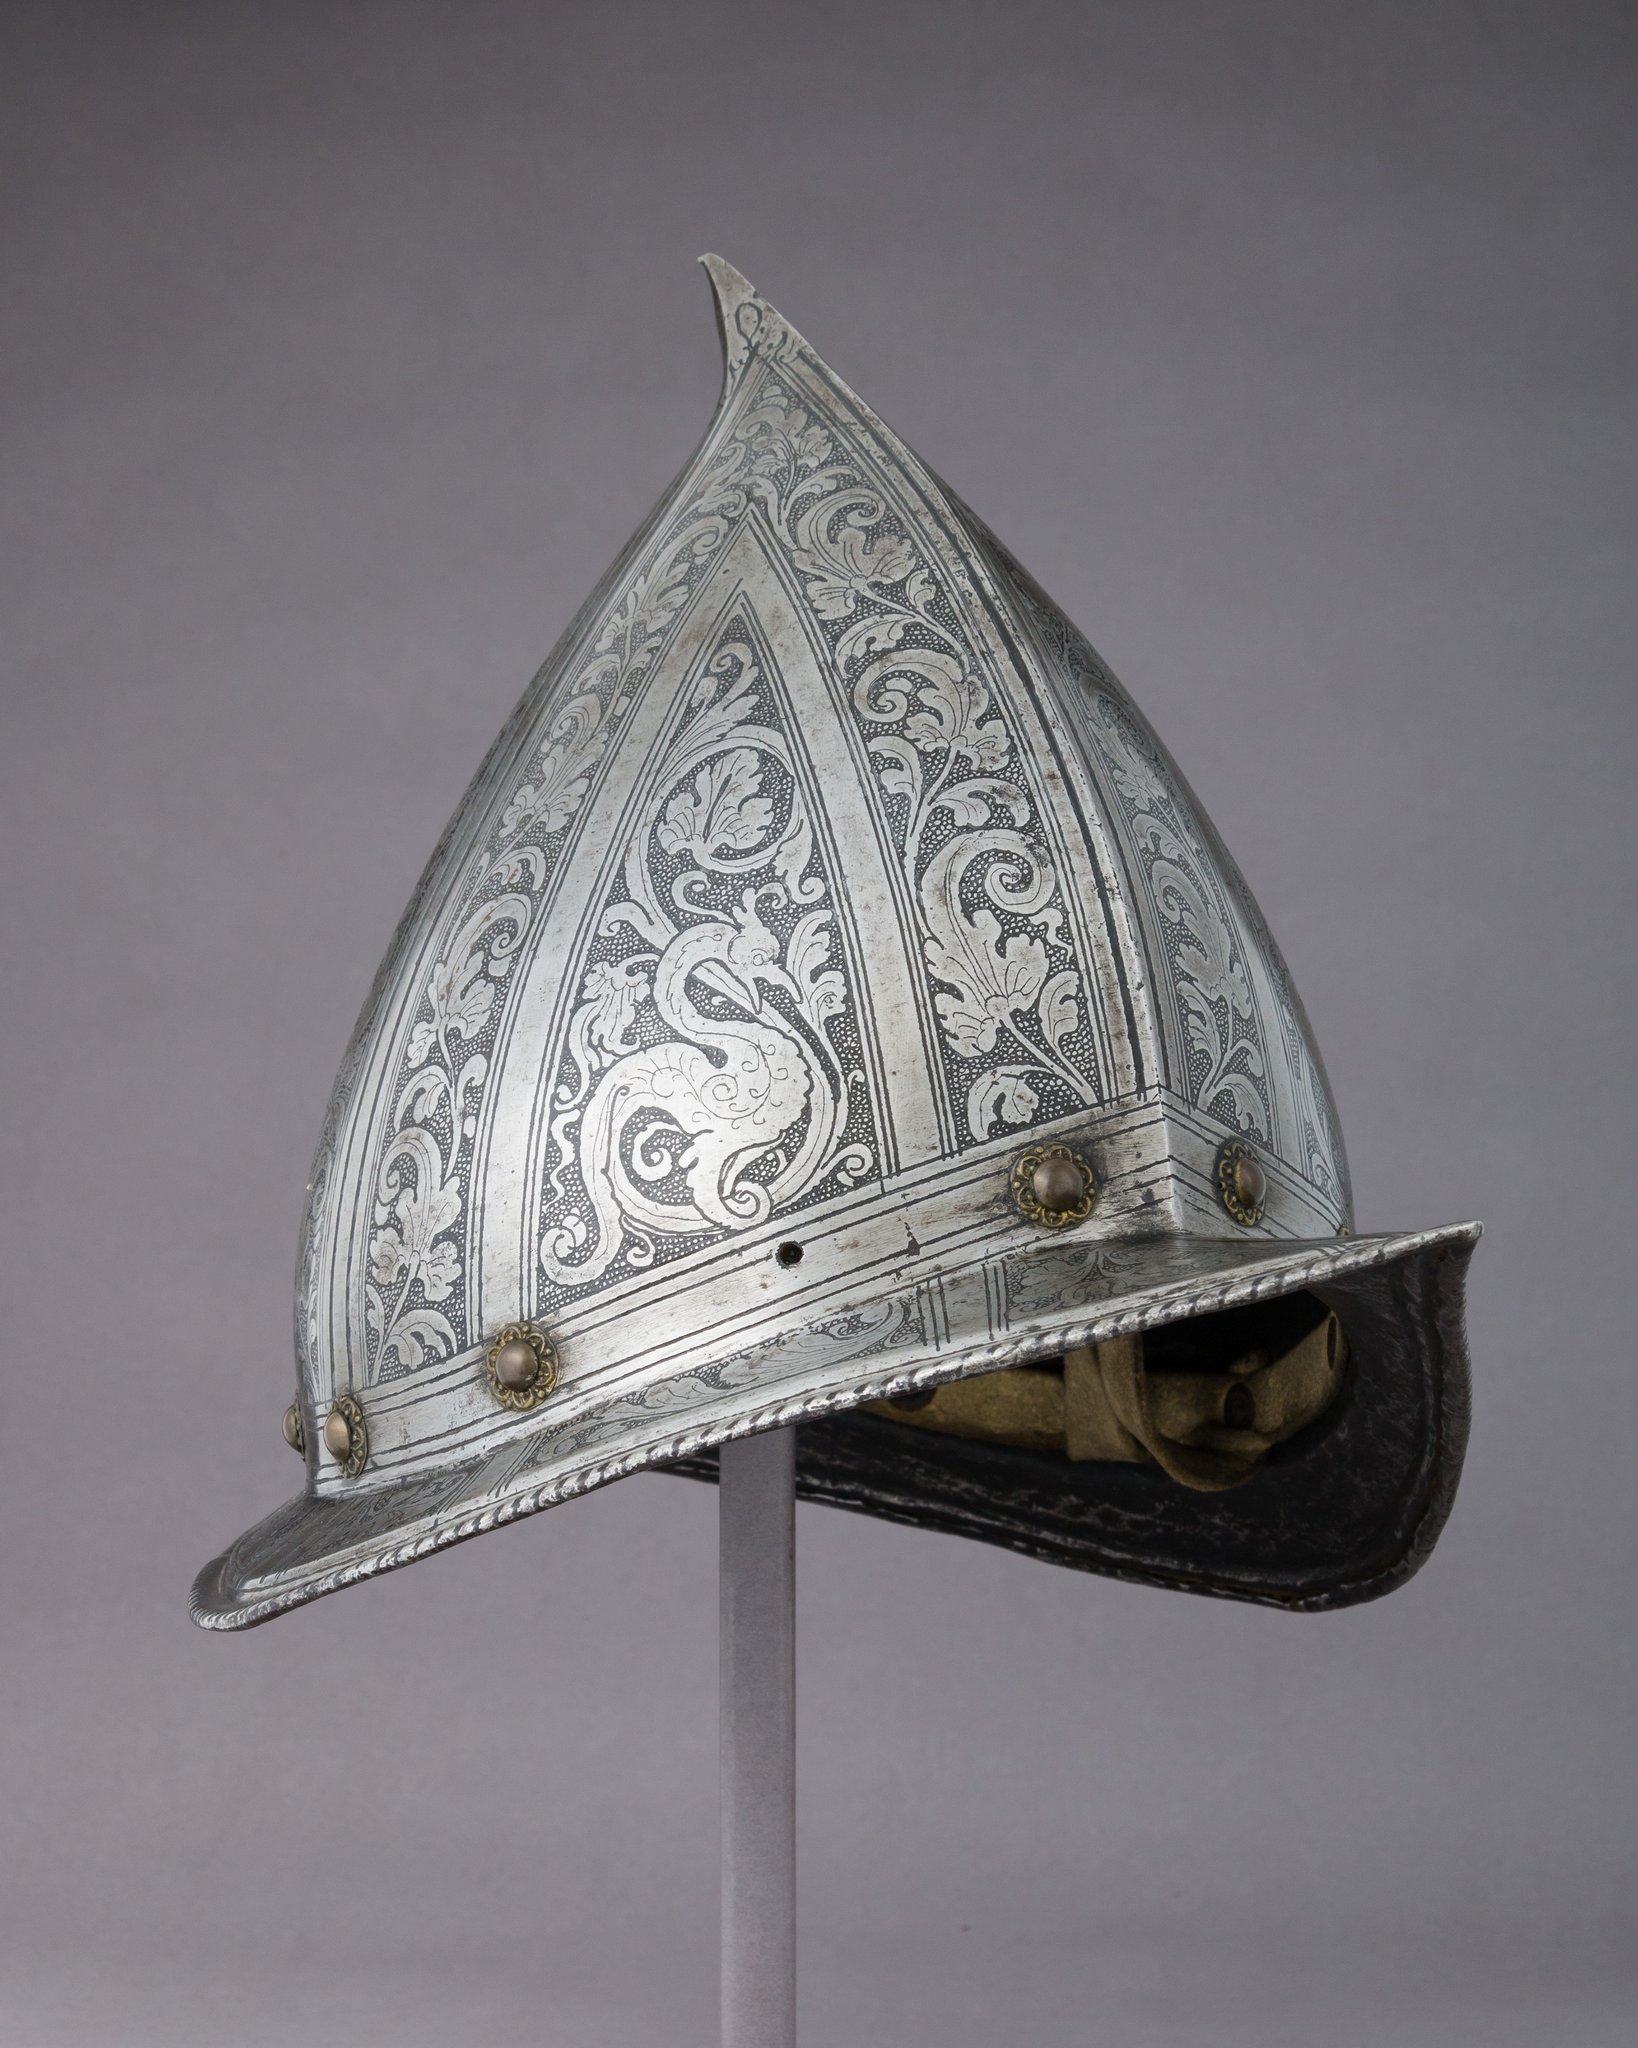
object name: morion cabasset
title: Morion-Cabasset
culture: italian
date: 1501-1600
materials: brass, leather, steel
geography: italy